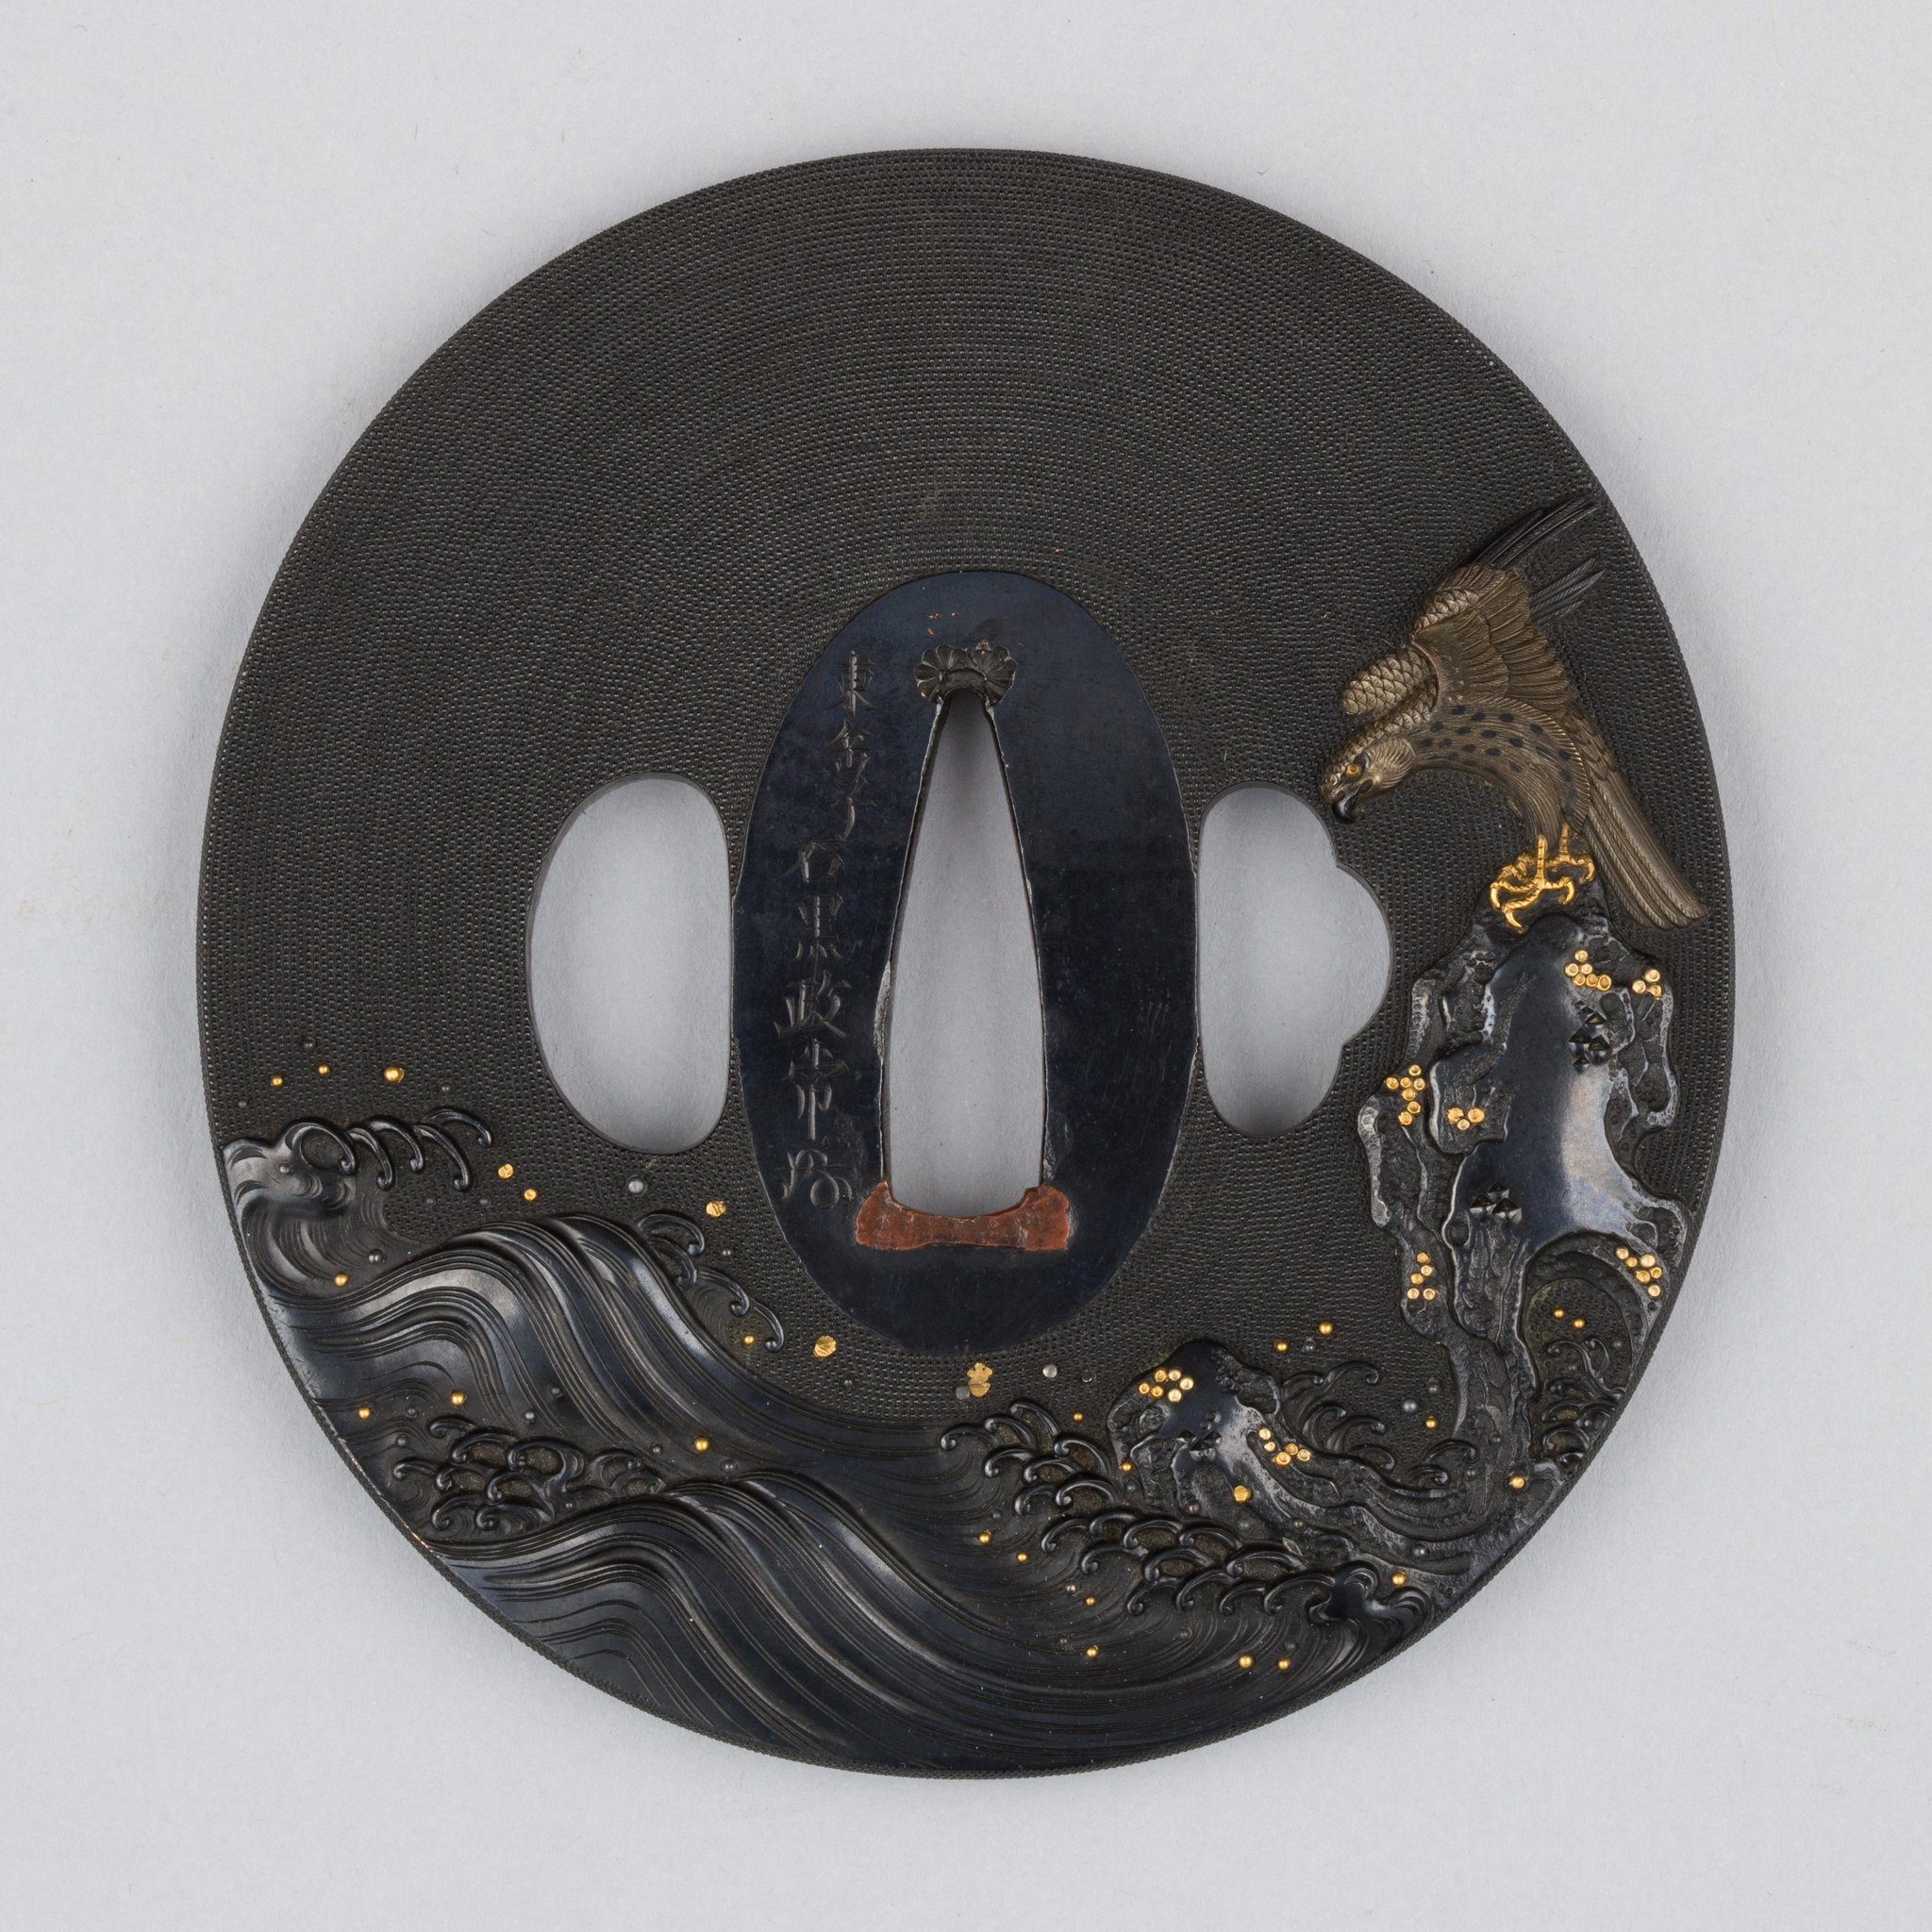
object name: sword guard tsuba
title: 波濤に岩上鷹図大小 Sword Guard (Tsuba)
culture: japanese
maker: 石黒政常 ishiguro masatsune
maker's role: fittings maker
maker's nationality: japanese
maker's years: 1760-1828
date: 1767-1833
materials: copper, gold alloy, silver alloy, gold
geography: japan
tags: eagles